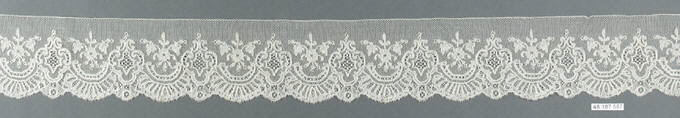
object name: border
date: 1834-1866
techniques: lace